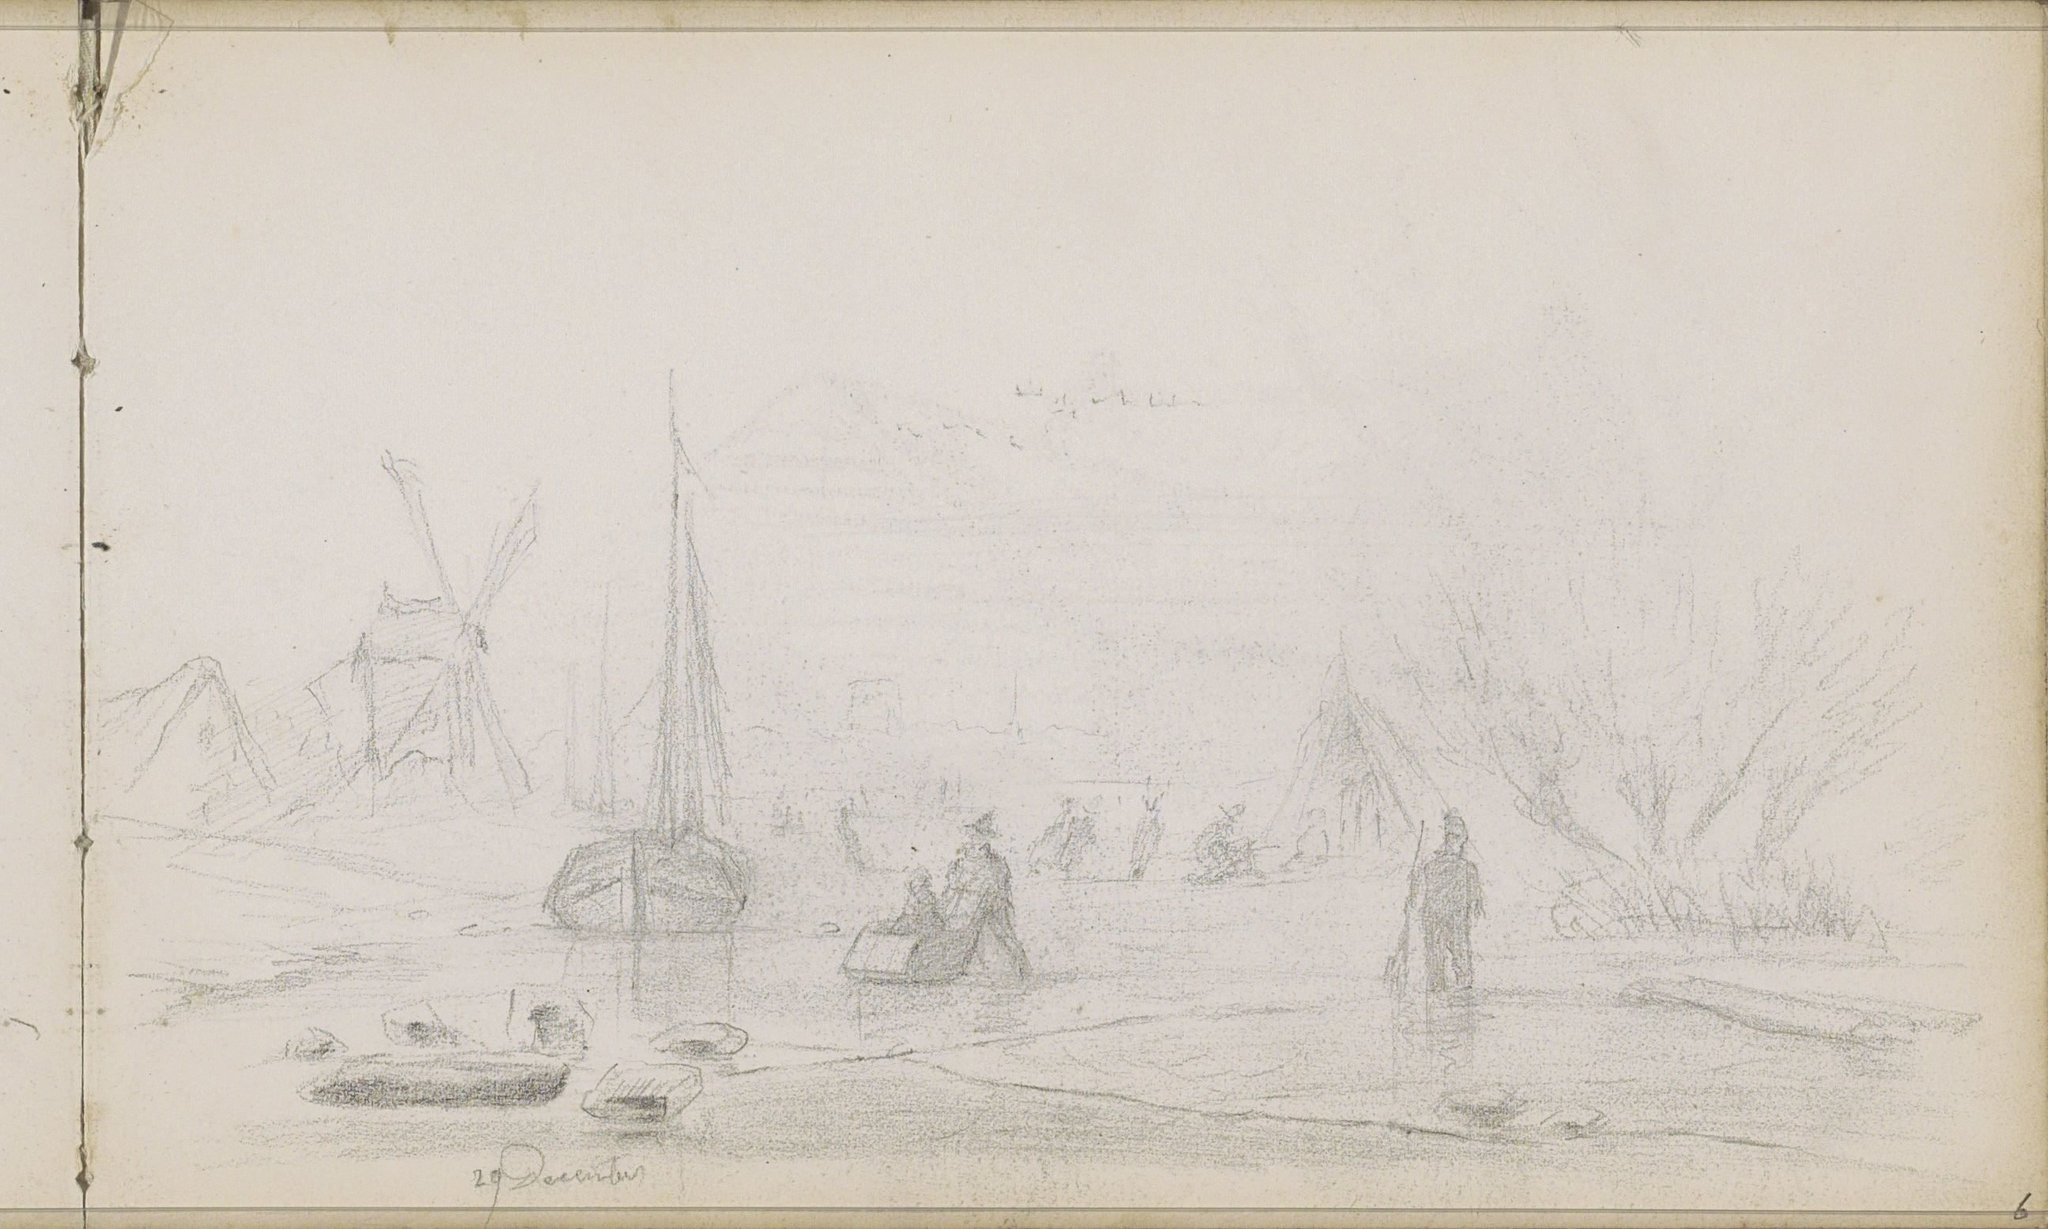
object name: sketchbook leaf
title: Winterlandschap met figuren op een bevroren vaart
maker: willem cornelis rip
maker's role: draughtsman, painter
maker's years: 1856-1922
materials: paper, pencil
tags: prospect of village, silhouette of village, ice ~ freezing weather, windmill in landscape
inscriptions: date: ‘29 December’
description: Op de achtergrond de contouren van een stad of dorp en een molen. Blad 6 recto uit een schetsboek met 46 bladen.